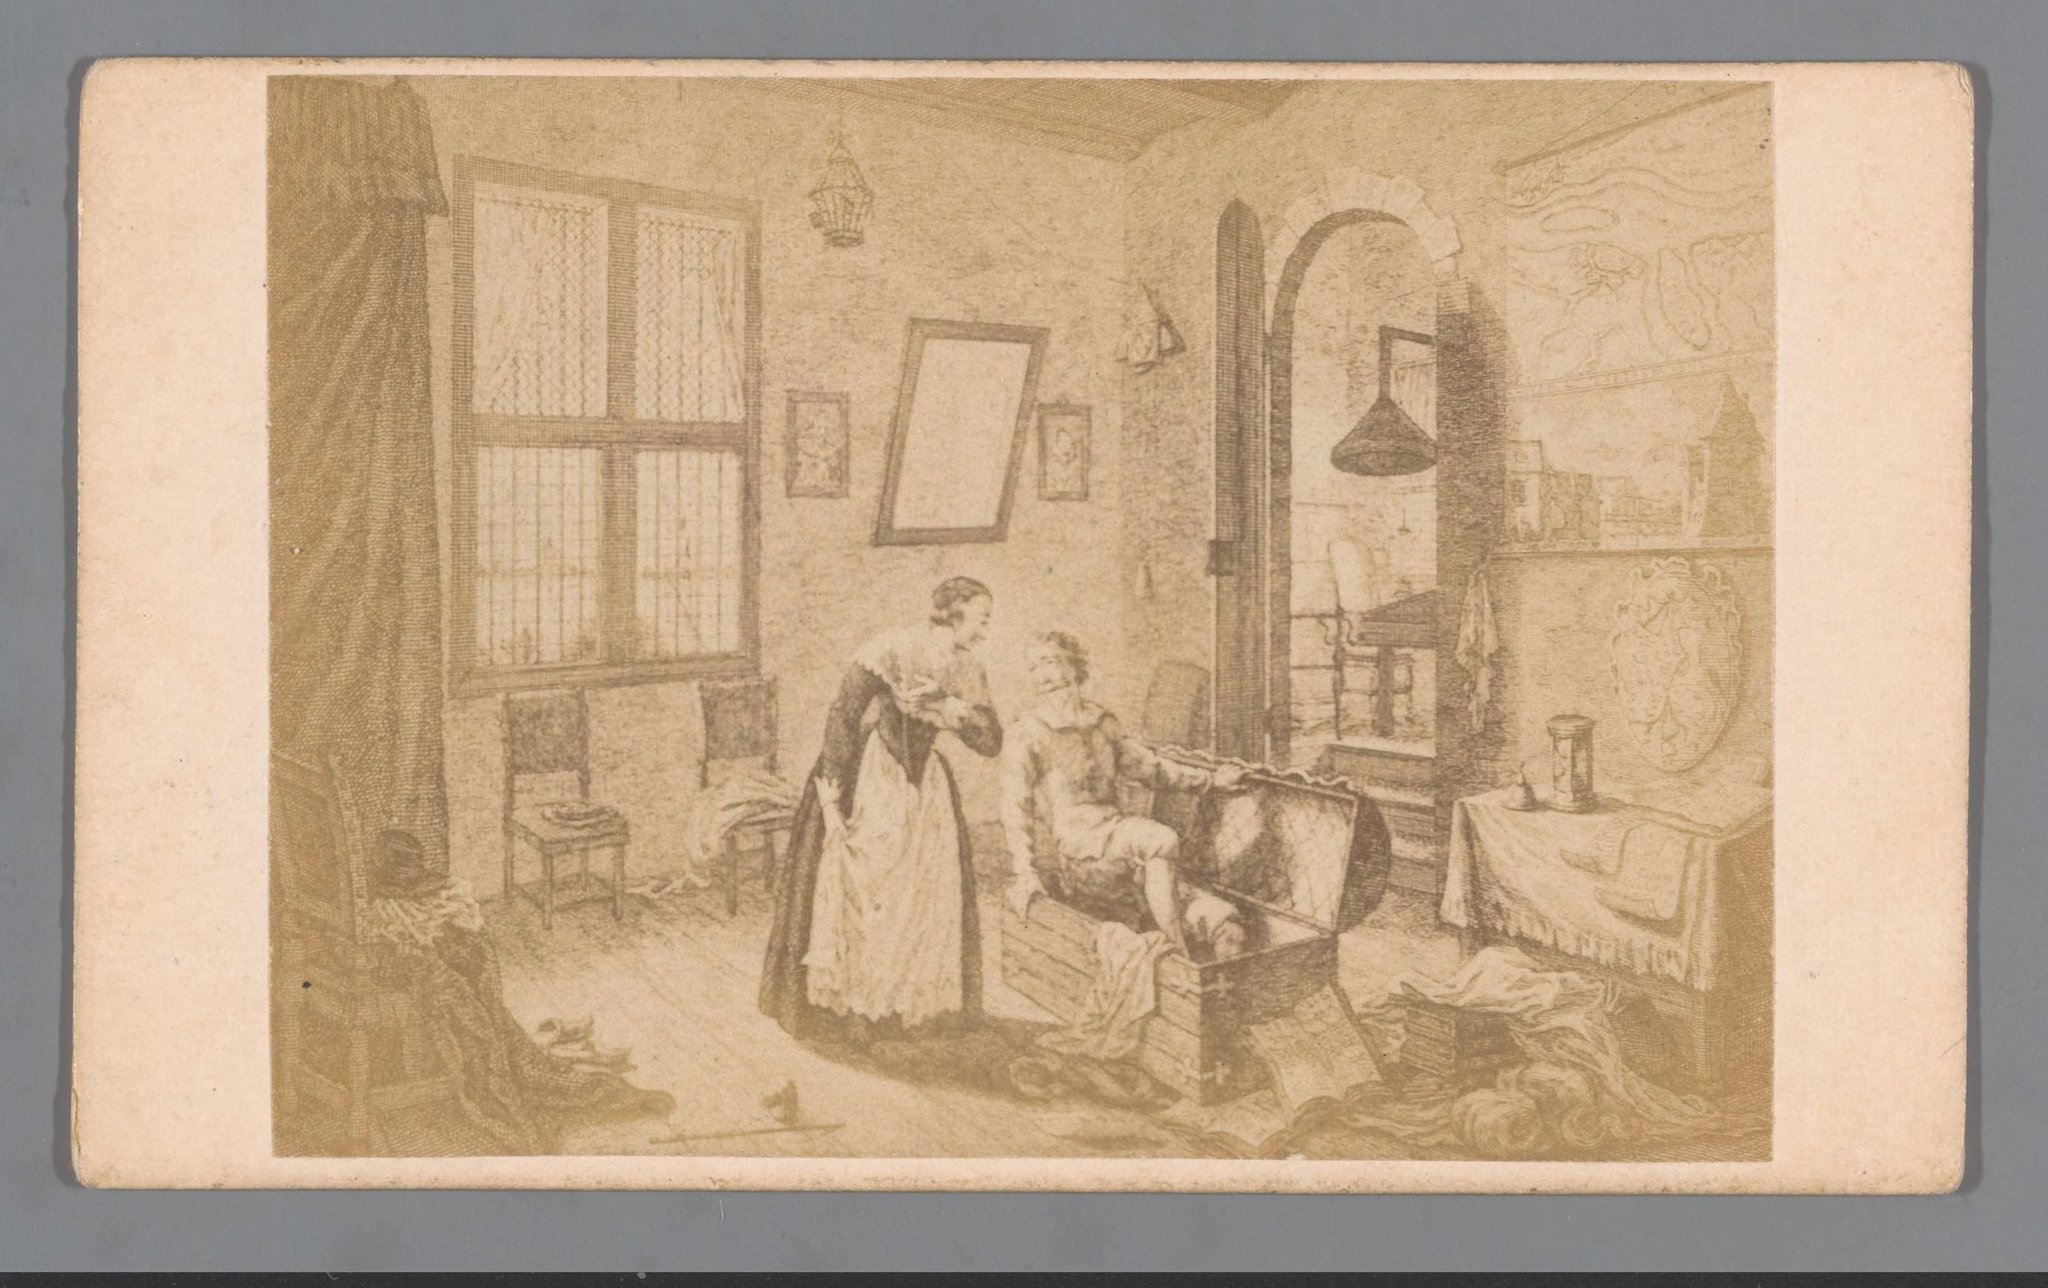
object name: carte de visite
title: Fotoreproductie van een gravure van de ontsnapping van Hugo de Groot uit Slot Loevestein in een boekenkist op 22 maart 1621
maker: Anonymous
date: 1850-1900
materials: cardboard, photographic support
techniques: albumen print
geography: netherlands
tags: delft, hugo de groot, escape, escape attempts, loevestein castle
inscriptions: number: ‘47’, inscription: ‘Huig de Groot (...) te Parijs.’, number: ‘47’